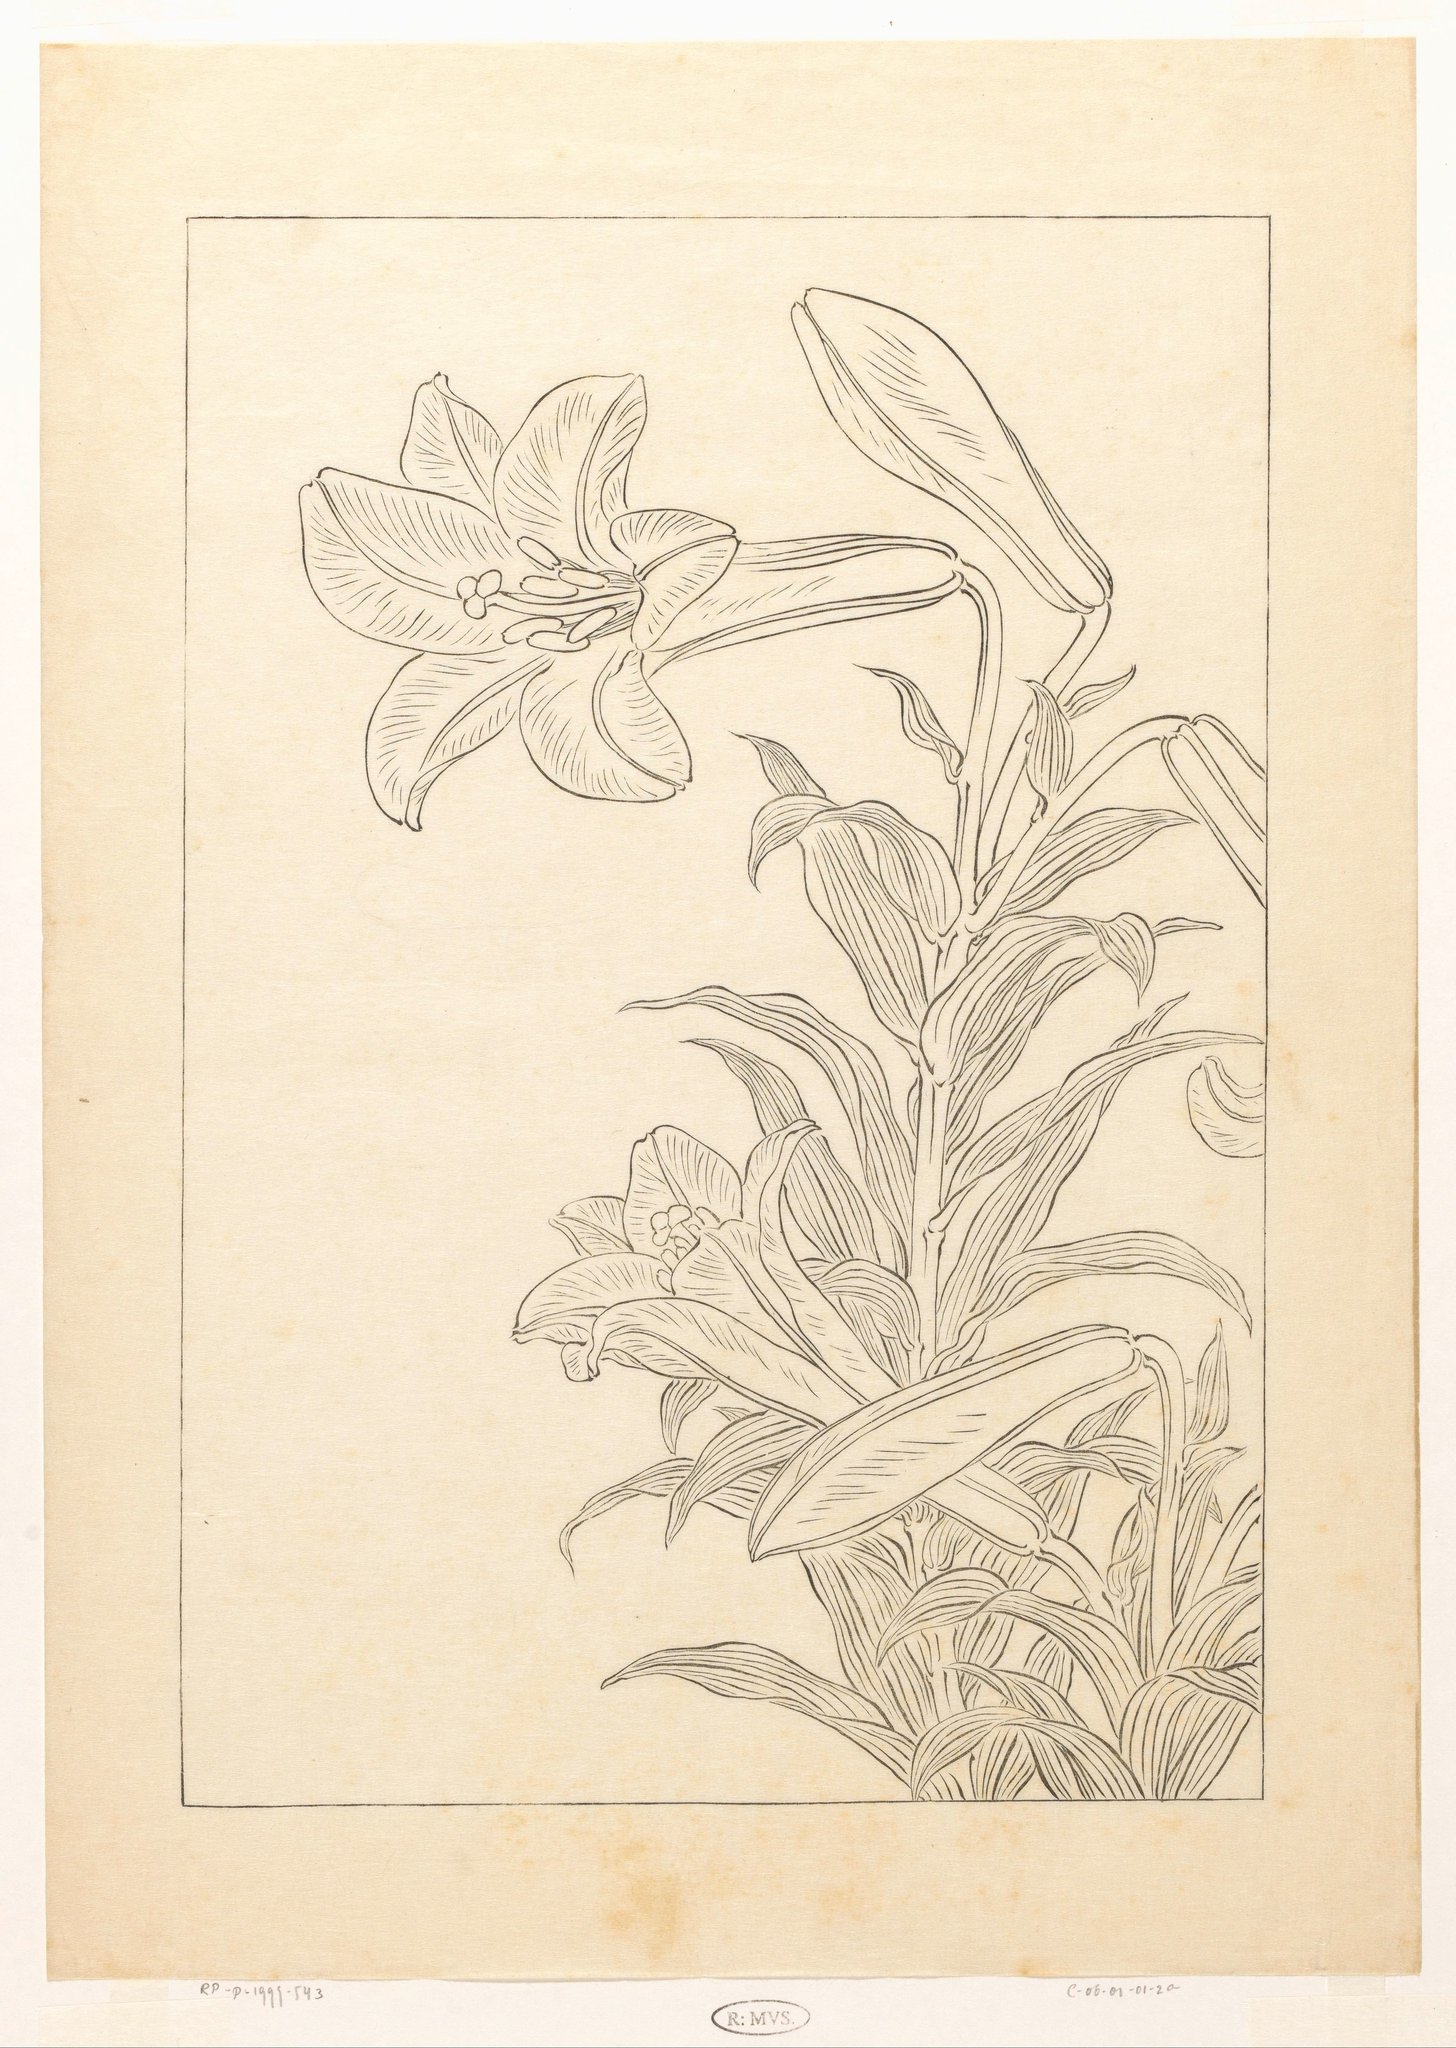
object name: print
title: Lelies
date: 1920-1930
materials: paper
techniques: woodcut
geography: japan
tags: flowers: lily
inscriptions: collector's mark: Lugt 2228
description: Lelies; twee bloeiend, drie in knop. Afdruk van het lijnblok.